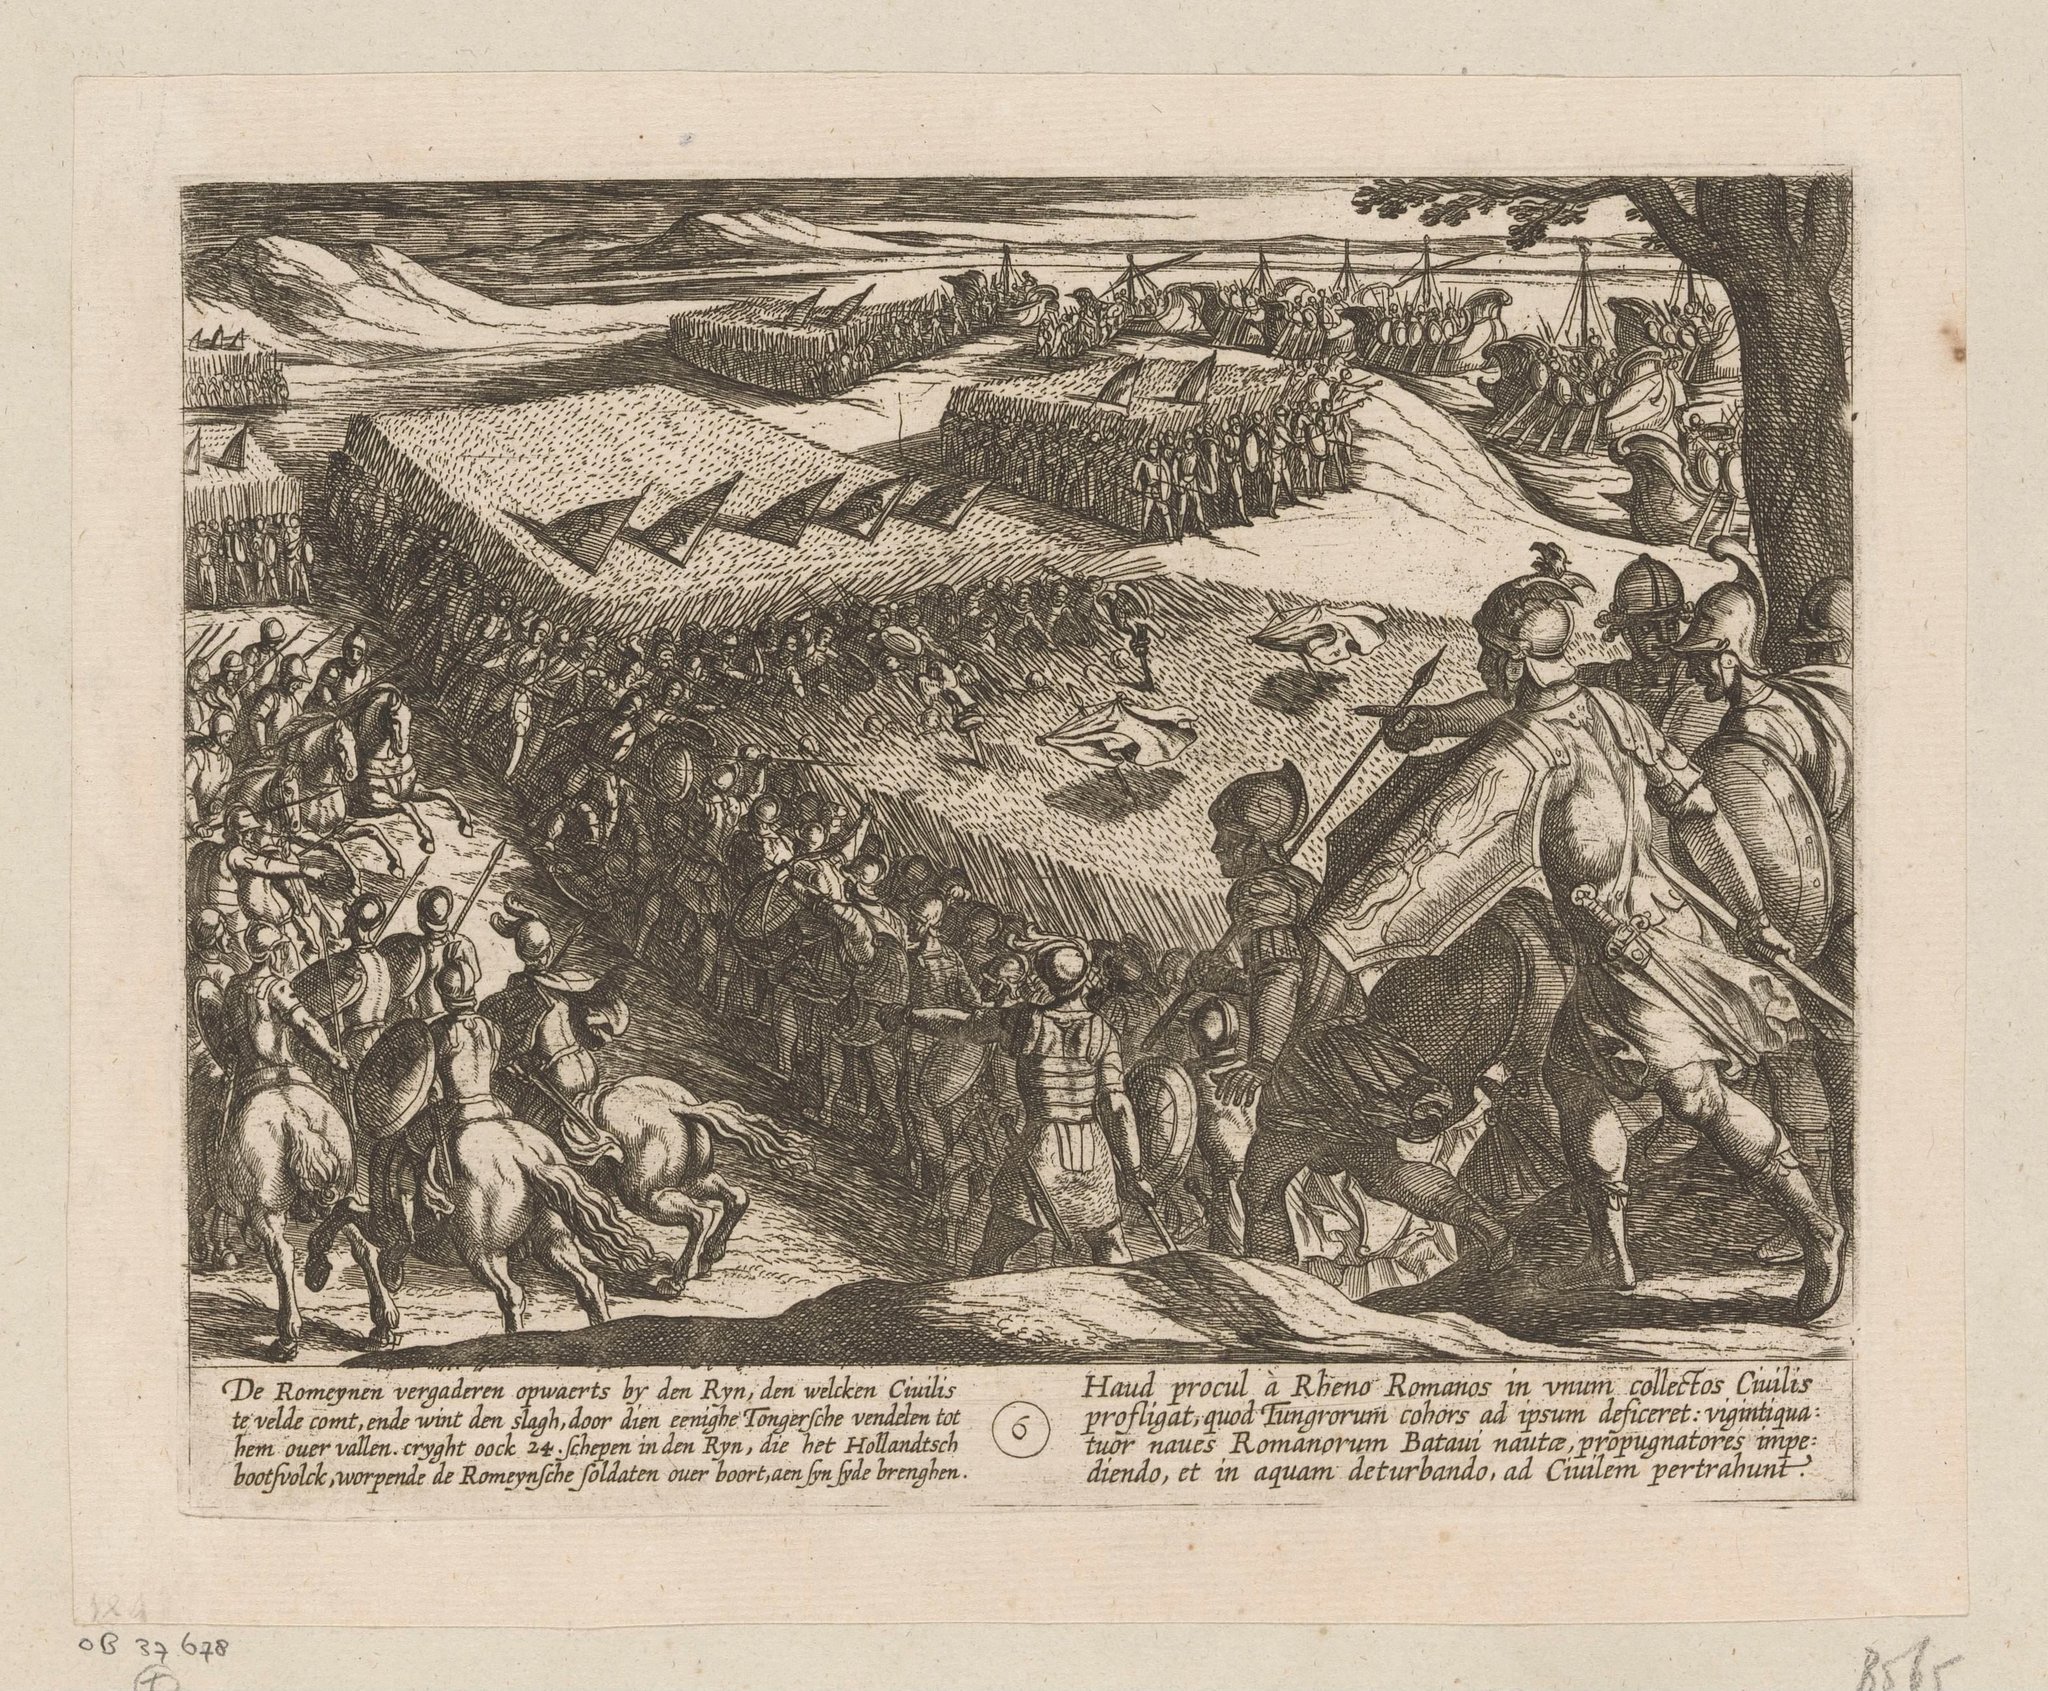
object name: history print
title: Romeinen verslagen bij de Rijn, 69-70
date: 1612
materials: paper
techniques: etching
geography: italy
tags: battle, fighting in general, extinct, 'historical' peoples (with name)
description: De Romeinen verslagen nabij de Rijn. Prent nummer 6 in de serie prenten over de Bataafse Opstand: Batavorum cum Romanis bellum / à Corn. Tacito lib. IV & V. : Hist. olim descriptum, figuris nunc aeneis expressum, auctore Othone Vaenio Lugdunobatava = De Batavische oft oude Hollandtsche oorloghe teghen de Romeynen. Otto Vaenius, Antwerpen 1612. Onderaan twee verzen van vier regels in het Nederlands en in het Latijn. Zonder tekst op achterzijde.